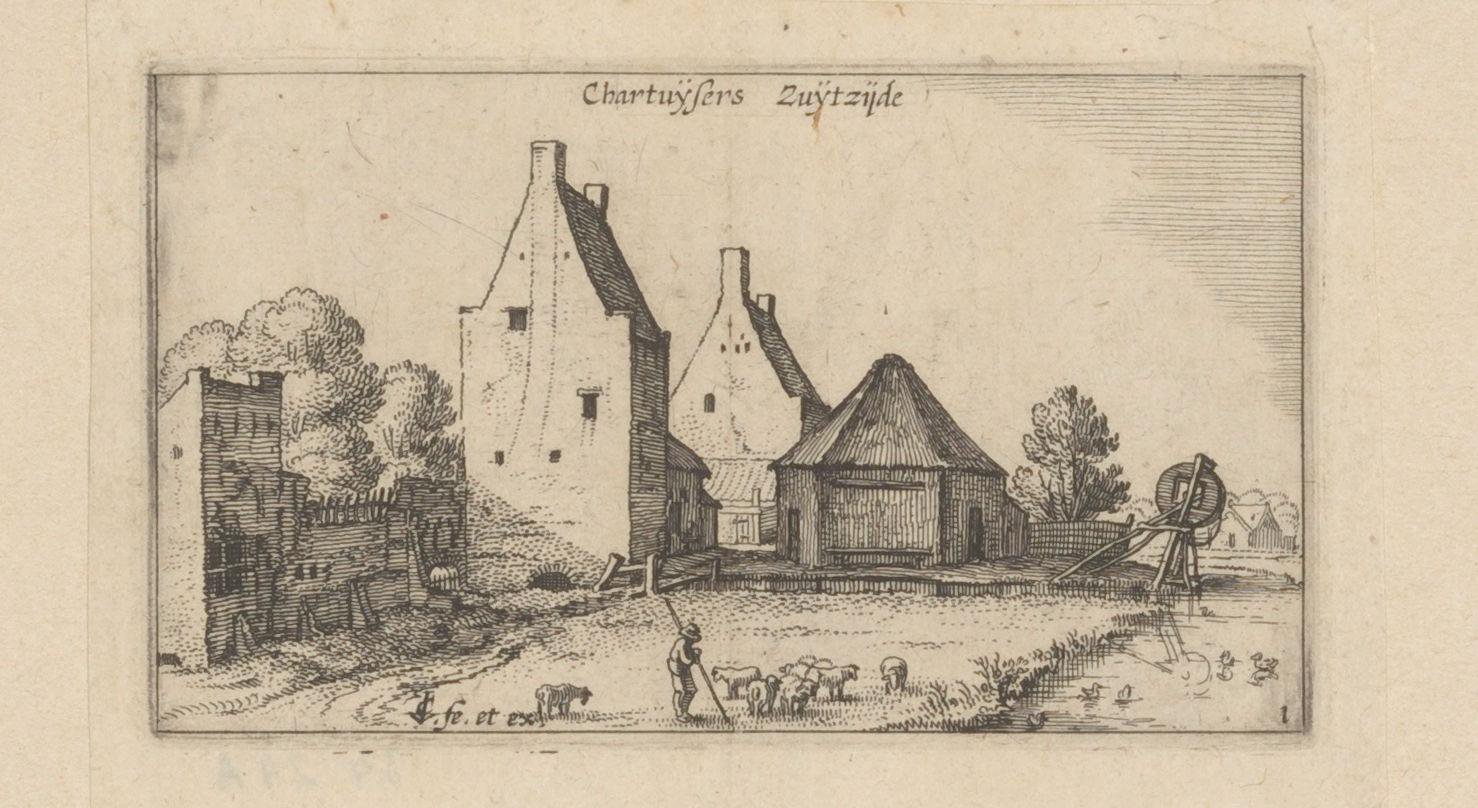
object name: print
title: Gezicht op de zuidzijde van het Kartuizerklooster te Amsterdam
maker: claes jansz. visscher (ii)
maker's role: draughtsman, print maker, publisher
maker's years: 1586-1652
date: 1605-1652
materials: paper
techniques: engraving, etching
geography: amsterdam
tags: herding, herdsman, herdswoman, shepherd, shepherdess, cowherd, etc., abbey, monastery, convent ~ roman catholic church, watermill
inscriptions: collector's mark: Lugt 1641b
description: Rechtsonder genummerd: 1. Onderwerpsrubriek binnen de Atlas Amsterdam: Kerkwezen: R.K. Gemeenten: Kloosters.